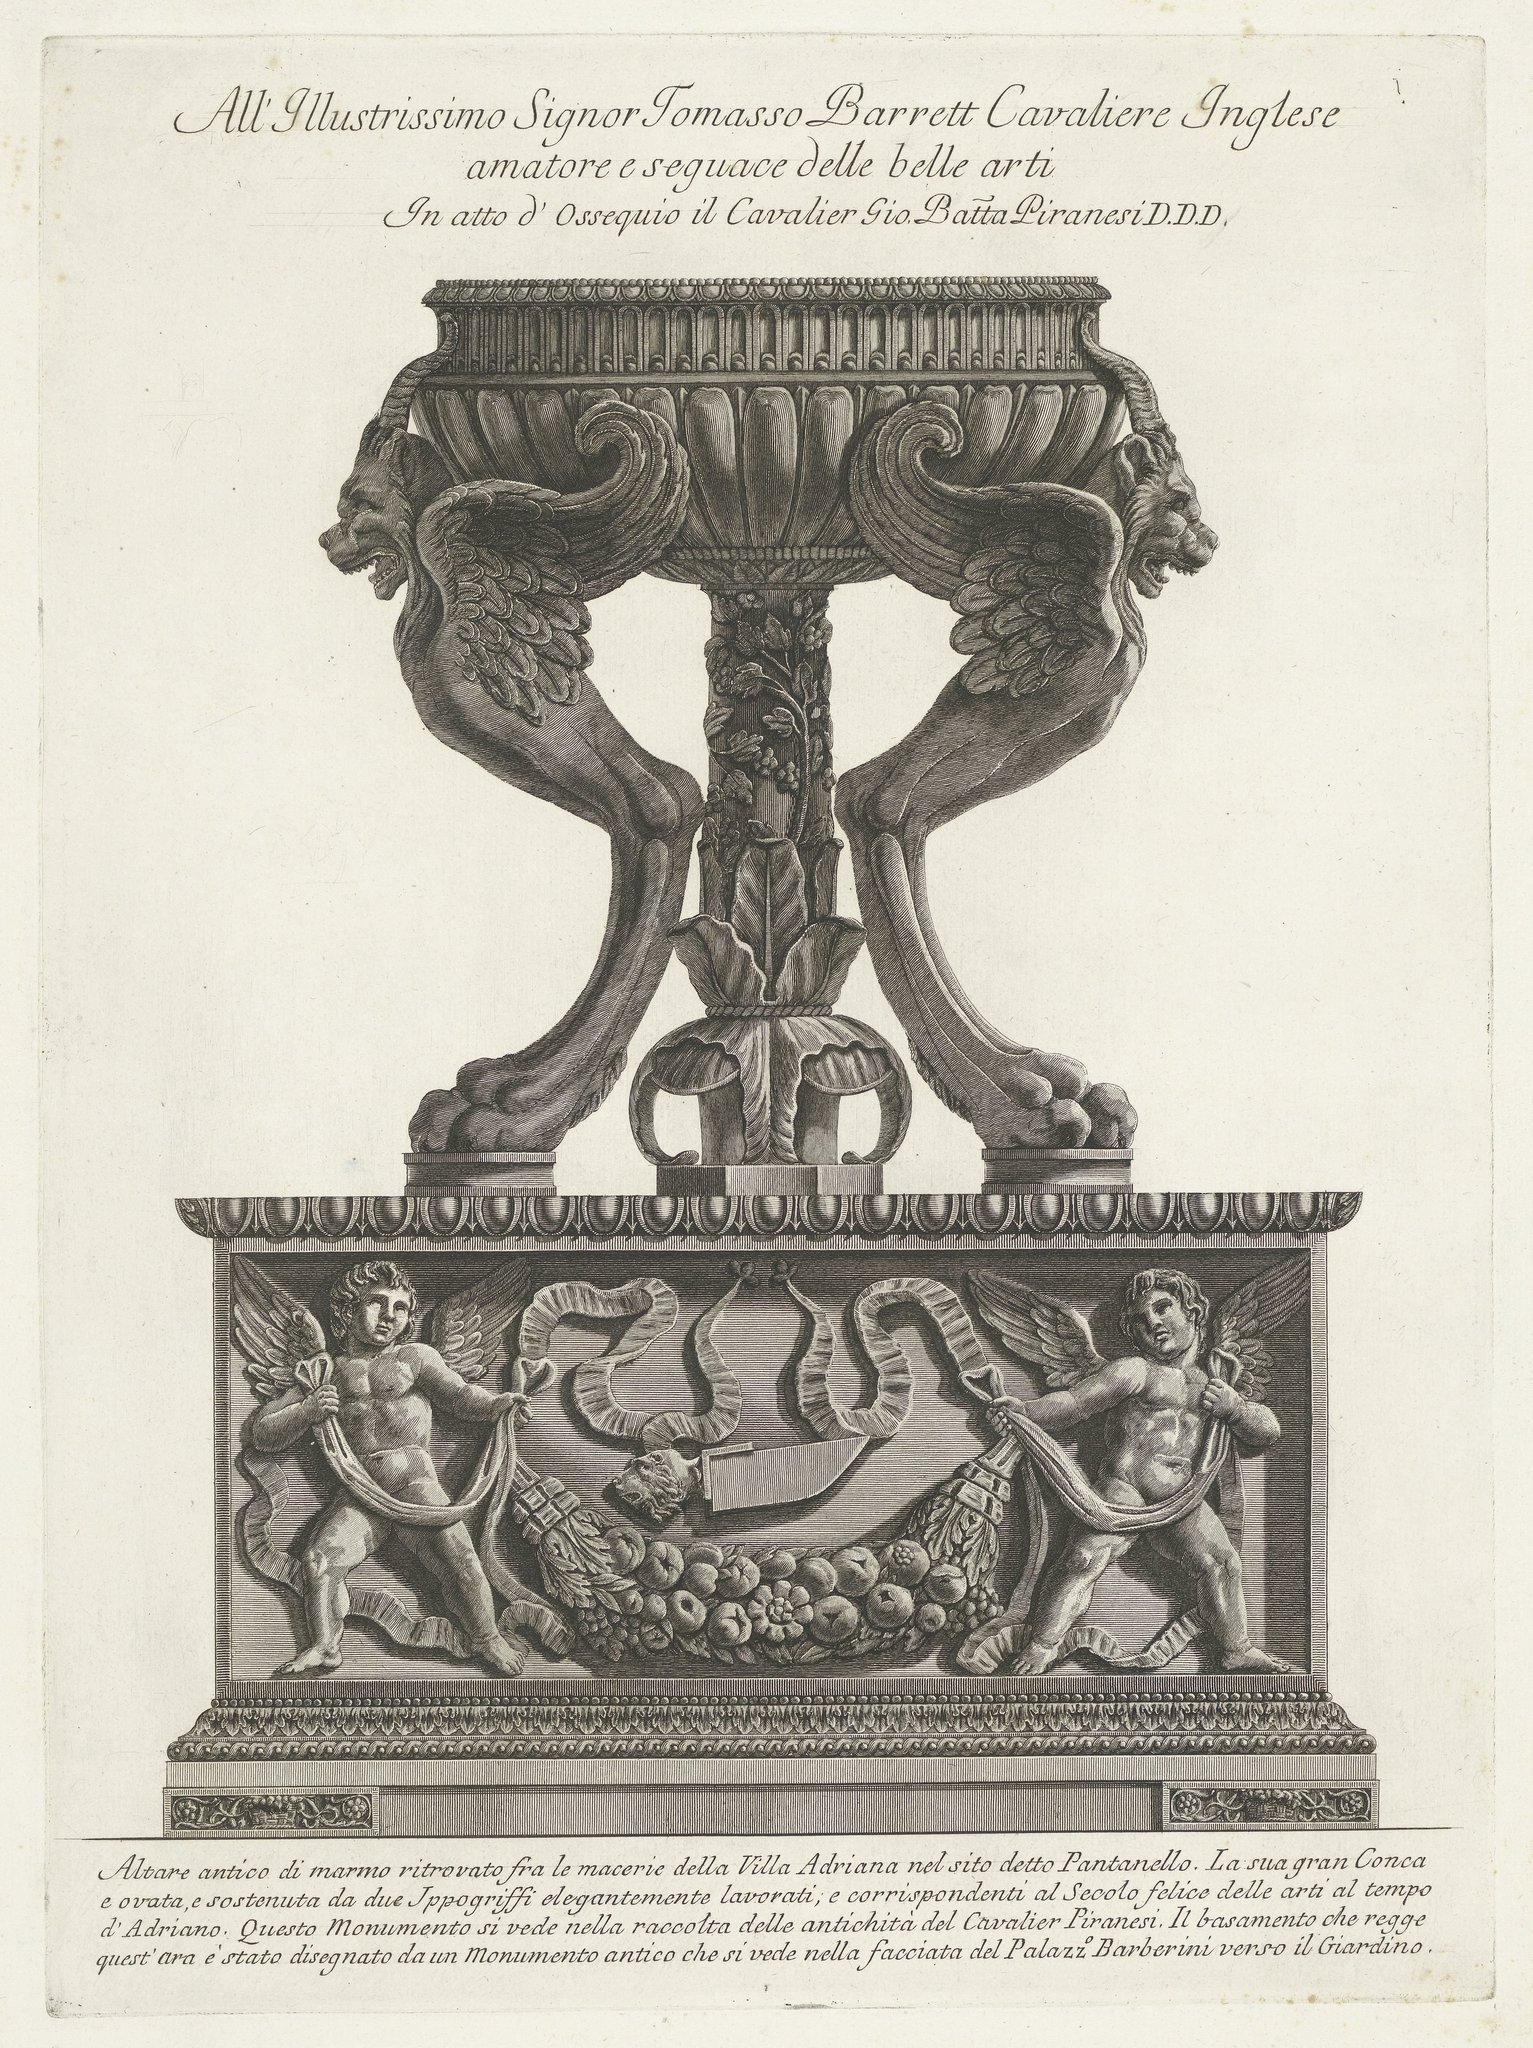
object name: print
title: Antiek altaar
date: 1778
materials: paper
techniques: etching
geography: rome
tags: altar ~ non-christian religions, altar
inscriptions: collector's mark: Lugt 2228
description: De 'Vasi'-reeks telt 110 prenten, verspreid over twee volumes met elk een eigen titelprent. Piranesi werd voor deze reeks geholpen door verschillende assistenten uit zijn werkplaats, waaronder zijn zoon Francesco die ook nog eens 8 platen toevoegde aan de reeks in 1779-1780.